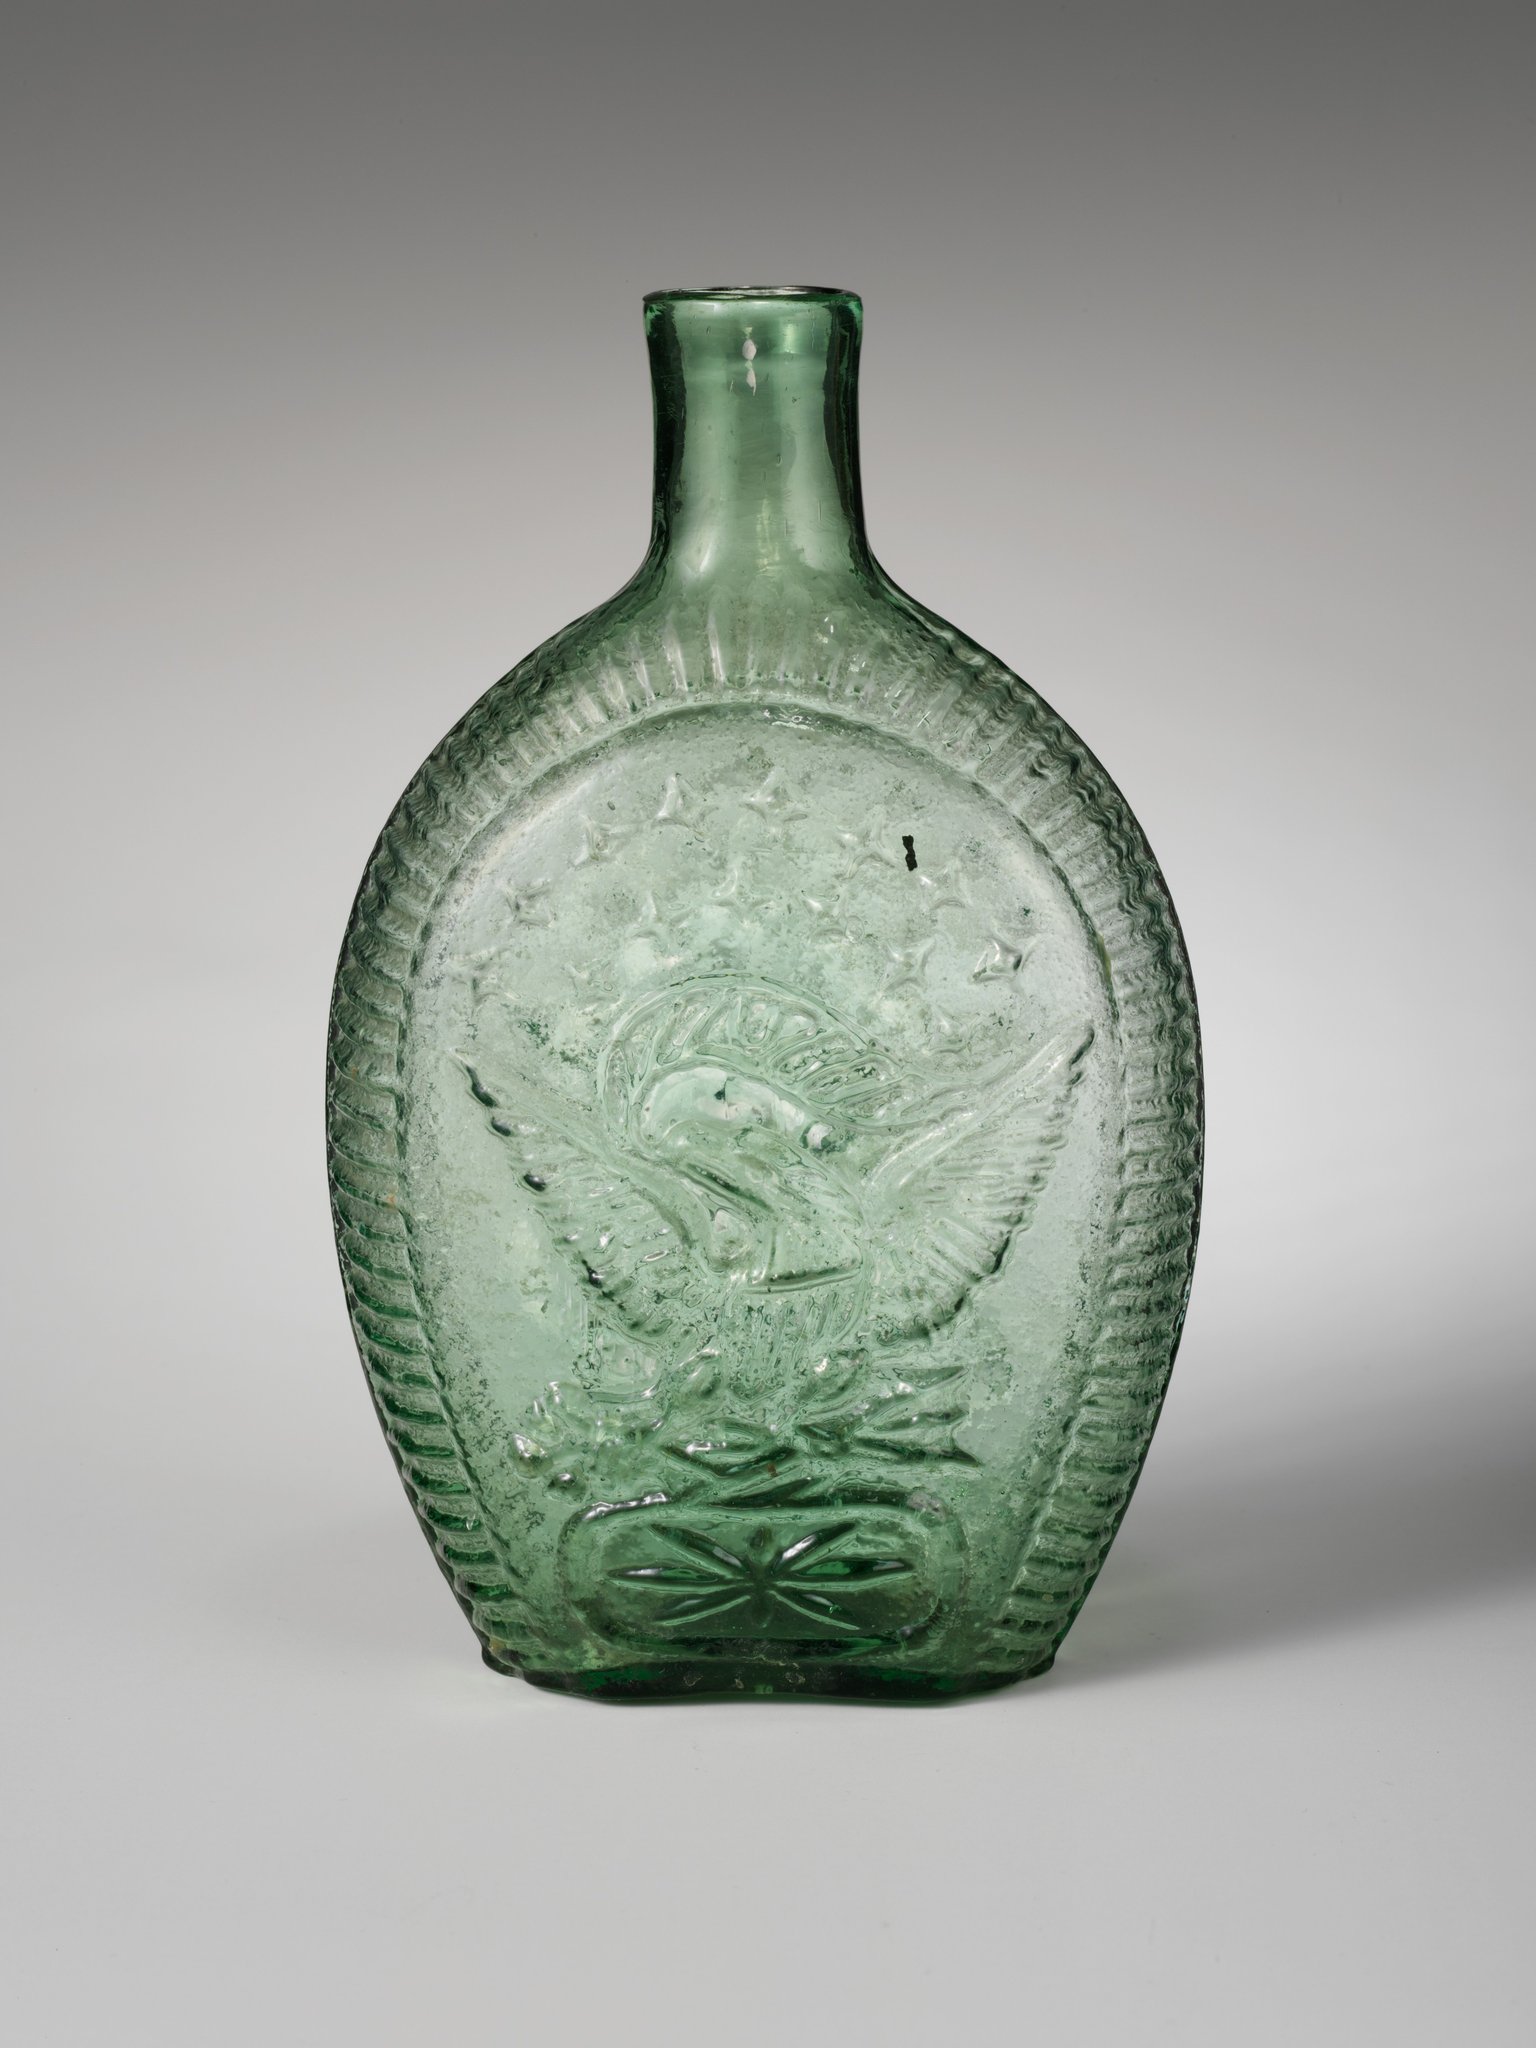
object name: flask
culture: american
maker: kentucky glass works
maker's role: maker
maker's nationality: american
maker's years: 1850-1855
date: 1840-1860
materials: glass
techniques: glassblowing, molding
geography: united states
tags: eagles